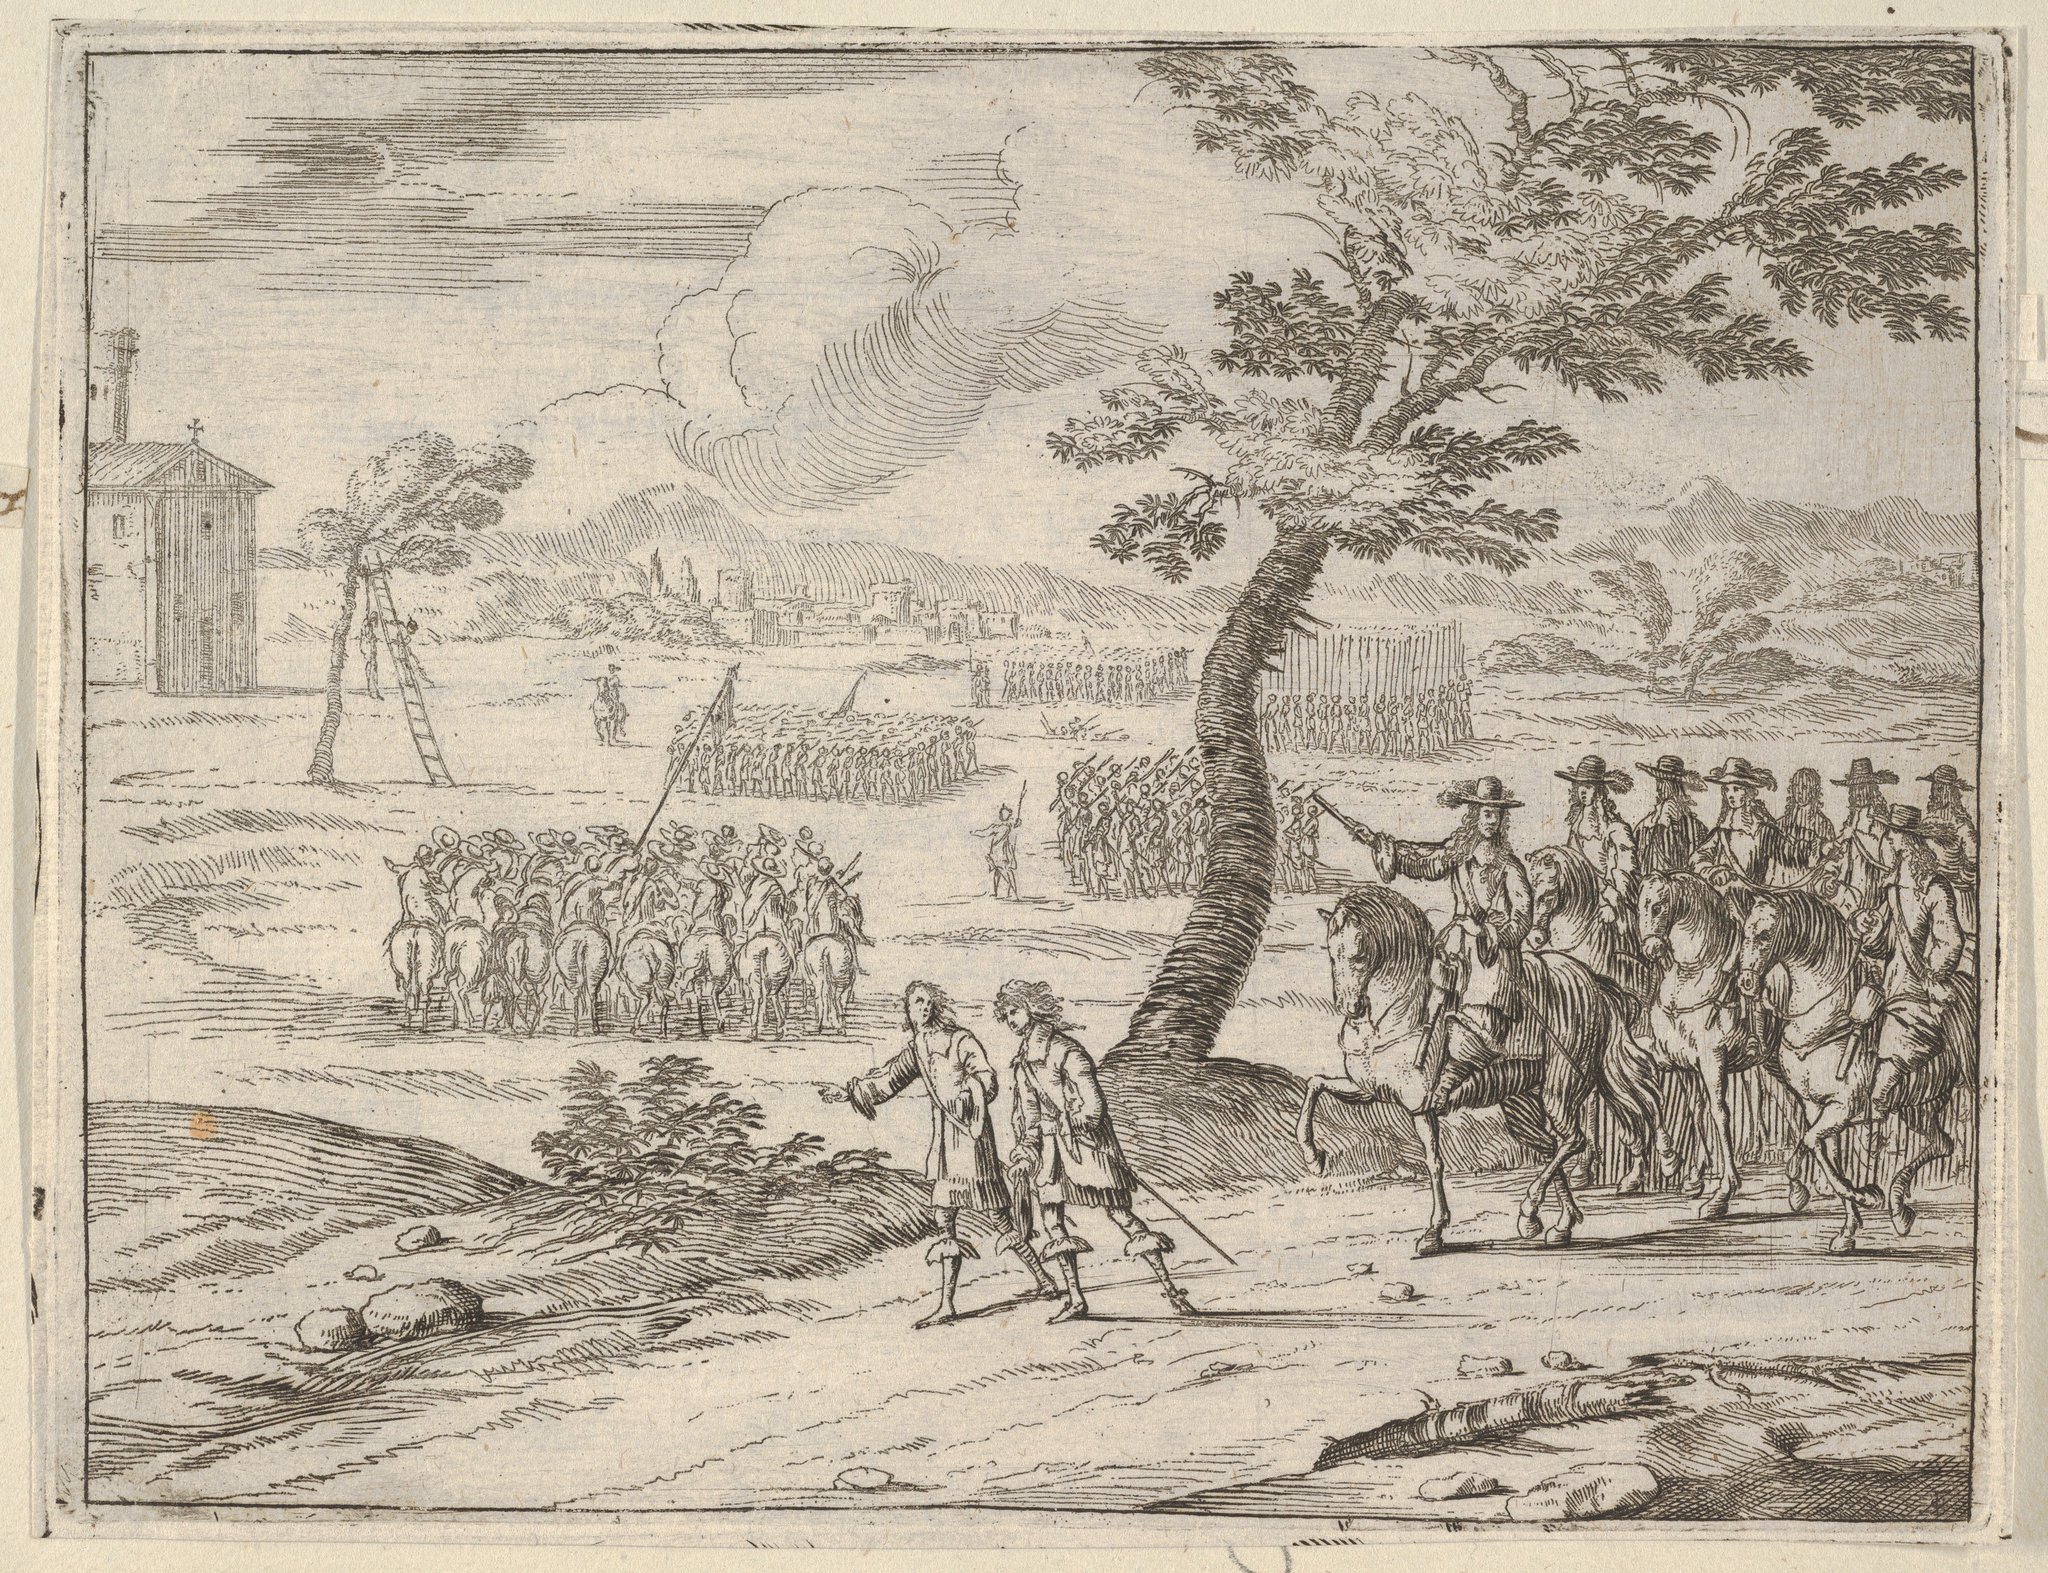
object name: print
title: Francesco I d'Este Punishes a Soldier by Death who had Stolen a Chalice from the Holy Church, from "L'Idea di un Principe ed Eroe Cristiano in Francesco I d'Este, di Modena e Reggio Duca VIII [...]"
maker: bartolomeo fenice (fénis)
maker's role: artist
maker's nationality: italian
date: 1659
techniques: etching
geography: italy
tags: soldiers,men,horses,trees,crowd